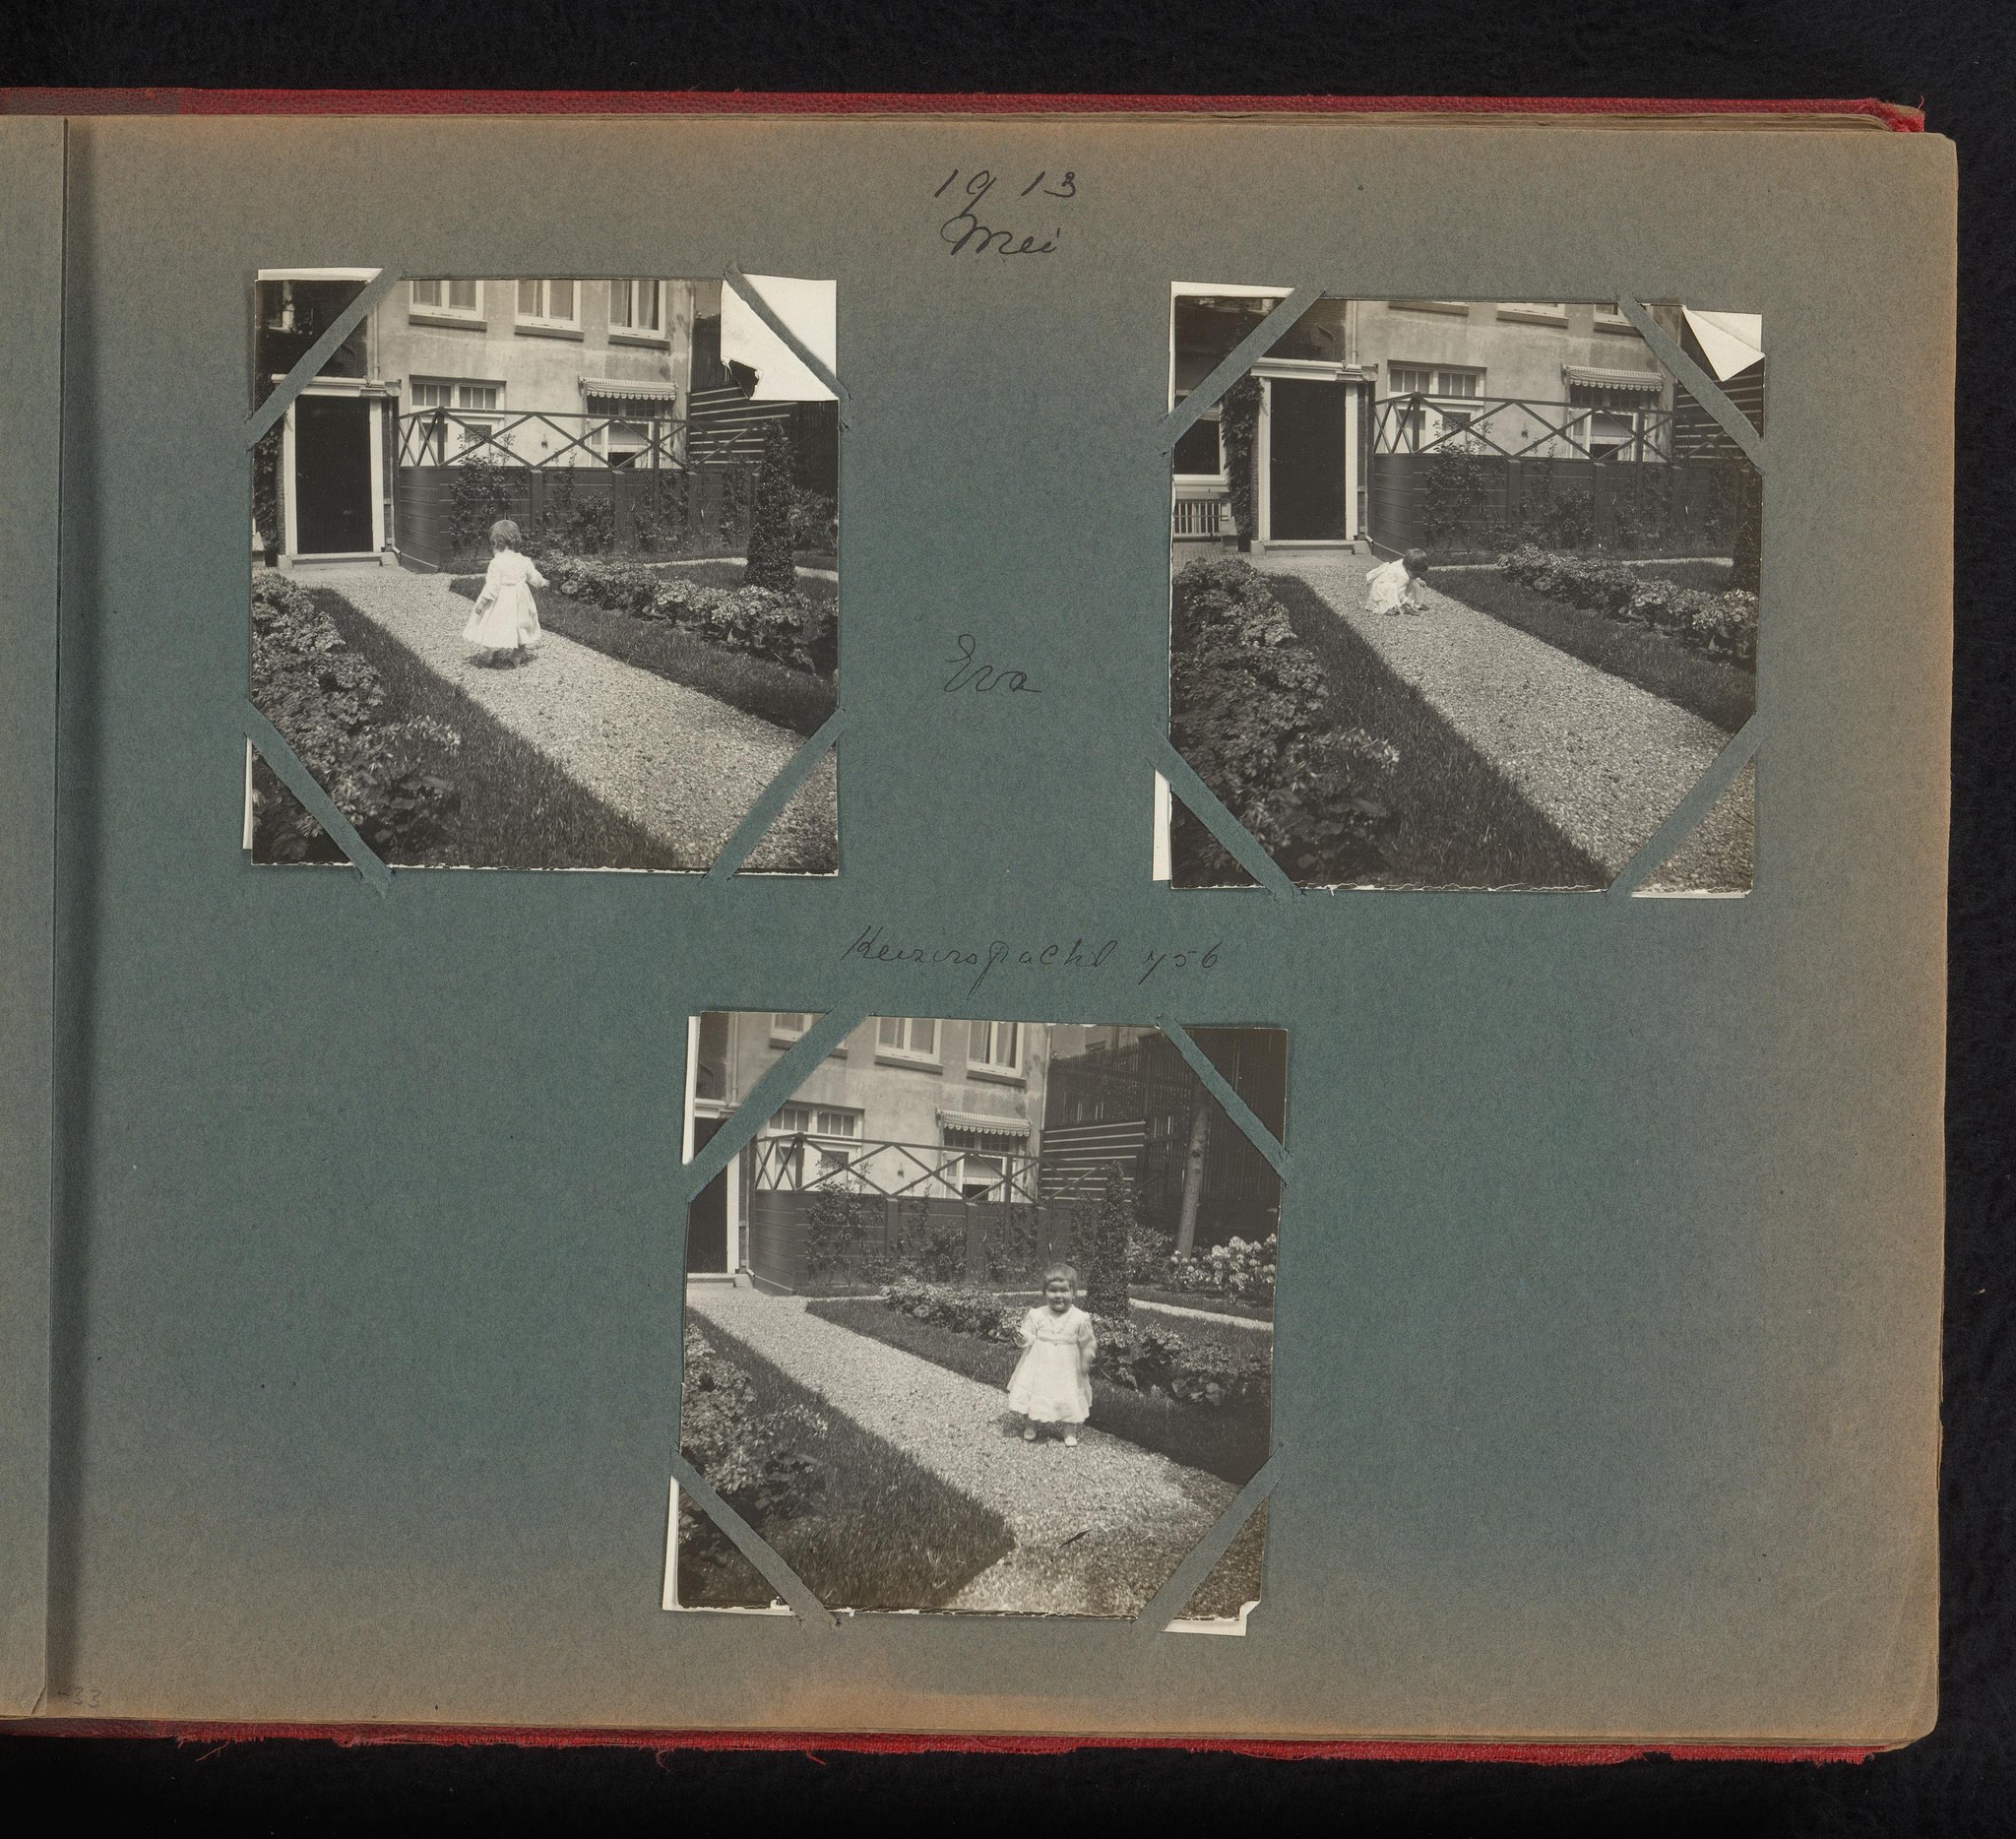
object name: photograph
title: Drie taferelen met Eva Boelen in de tuin van Keizersgracht 756 in Amsterdam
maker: charlotte alida boelen-matthes (lot)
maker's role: amateurfotograaf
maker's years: 1889-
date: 1905-1913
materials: paper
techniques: gelatin silver print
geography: amsterdam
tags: amsterdam, eva charlotte pennink-boelen, garden, toddler (female)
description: Deze foto's zijn onderdeel van een album.